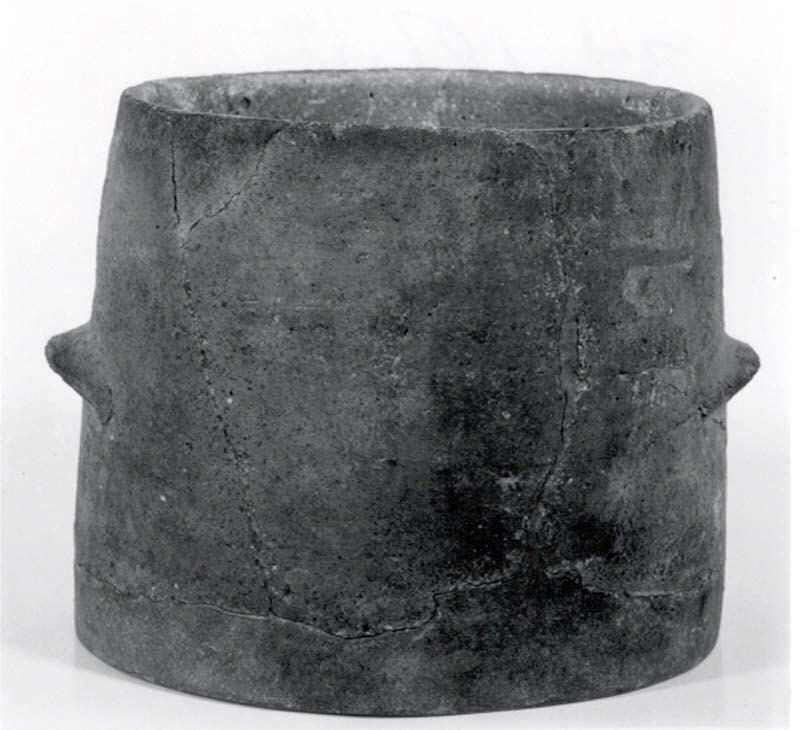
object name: large jar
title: Jar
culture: sasanian or islamic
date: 601-800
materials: ceramic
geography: iran